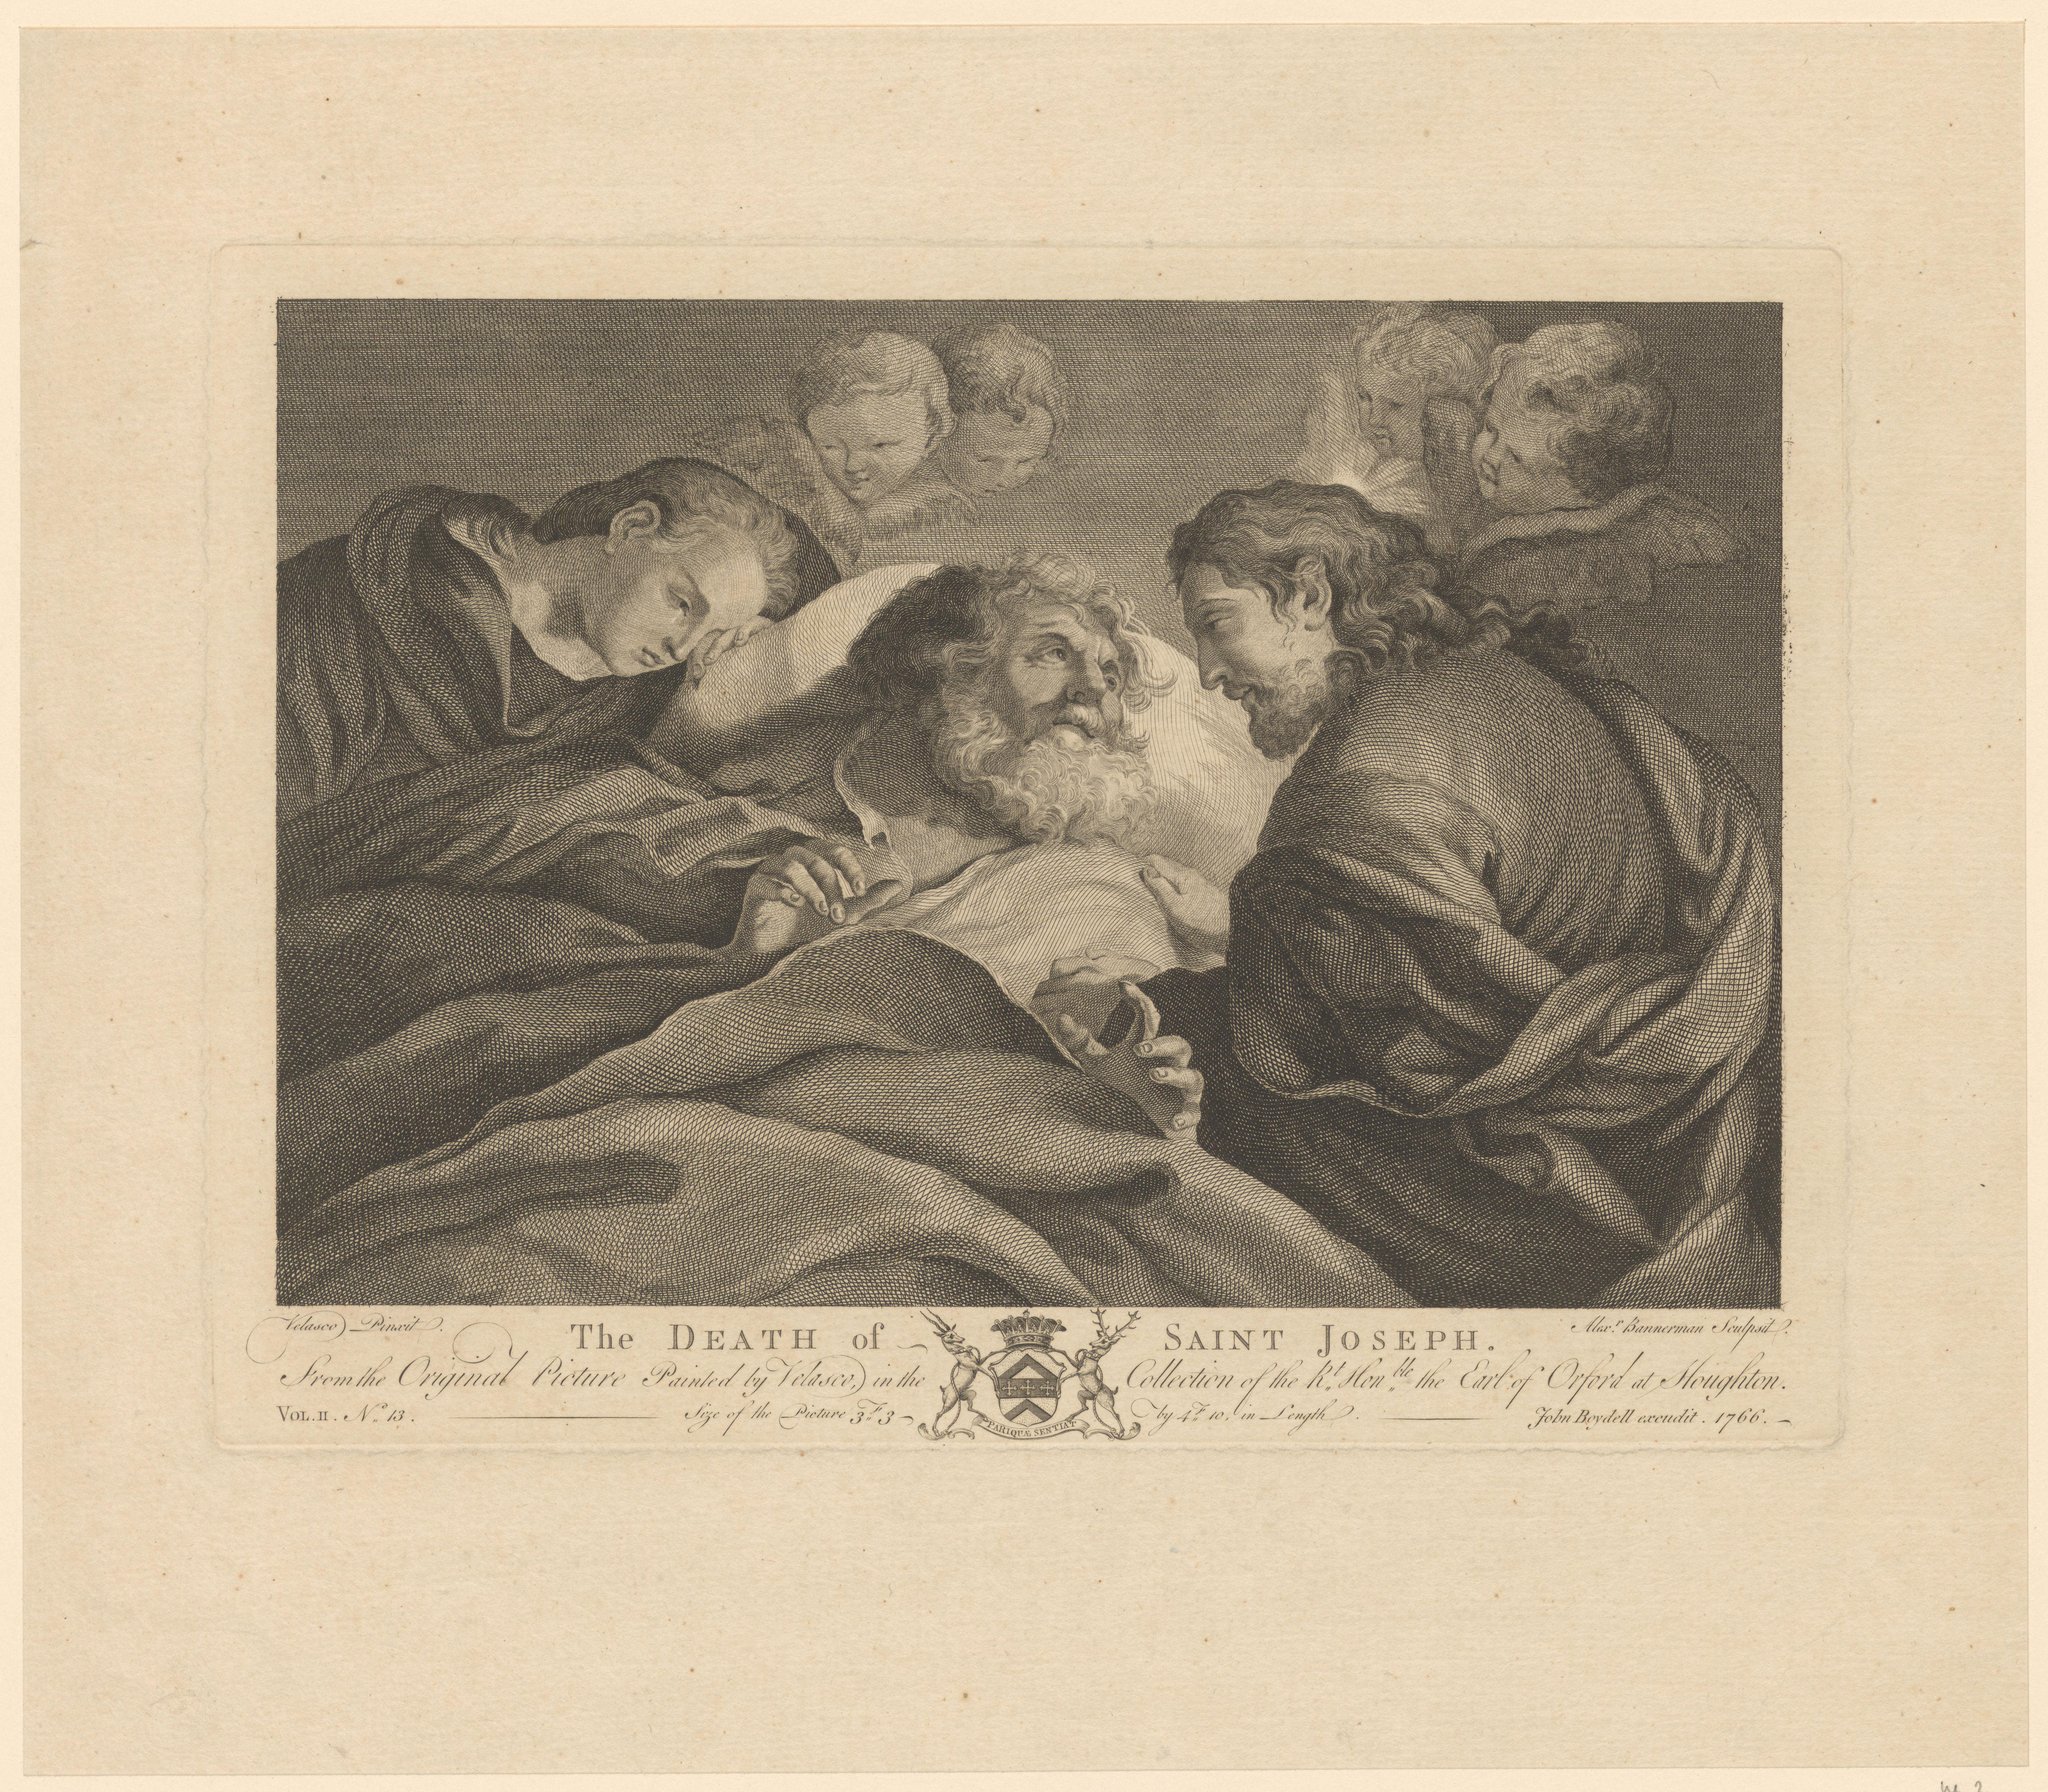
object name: print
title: The death of Saint Joseph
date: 1766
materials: paper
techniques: engraving, etching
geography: england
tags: joseph's death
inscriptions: collector's mark: Lugt 2228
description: Vanaf 1763 tot 1786 publiceerde John Boydell prenten naar schilderijen uit Engelse collecties. Deze waren vanaf 1769 gebonden verkrijgbaar.